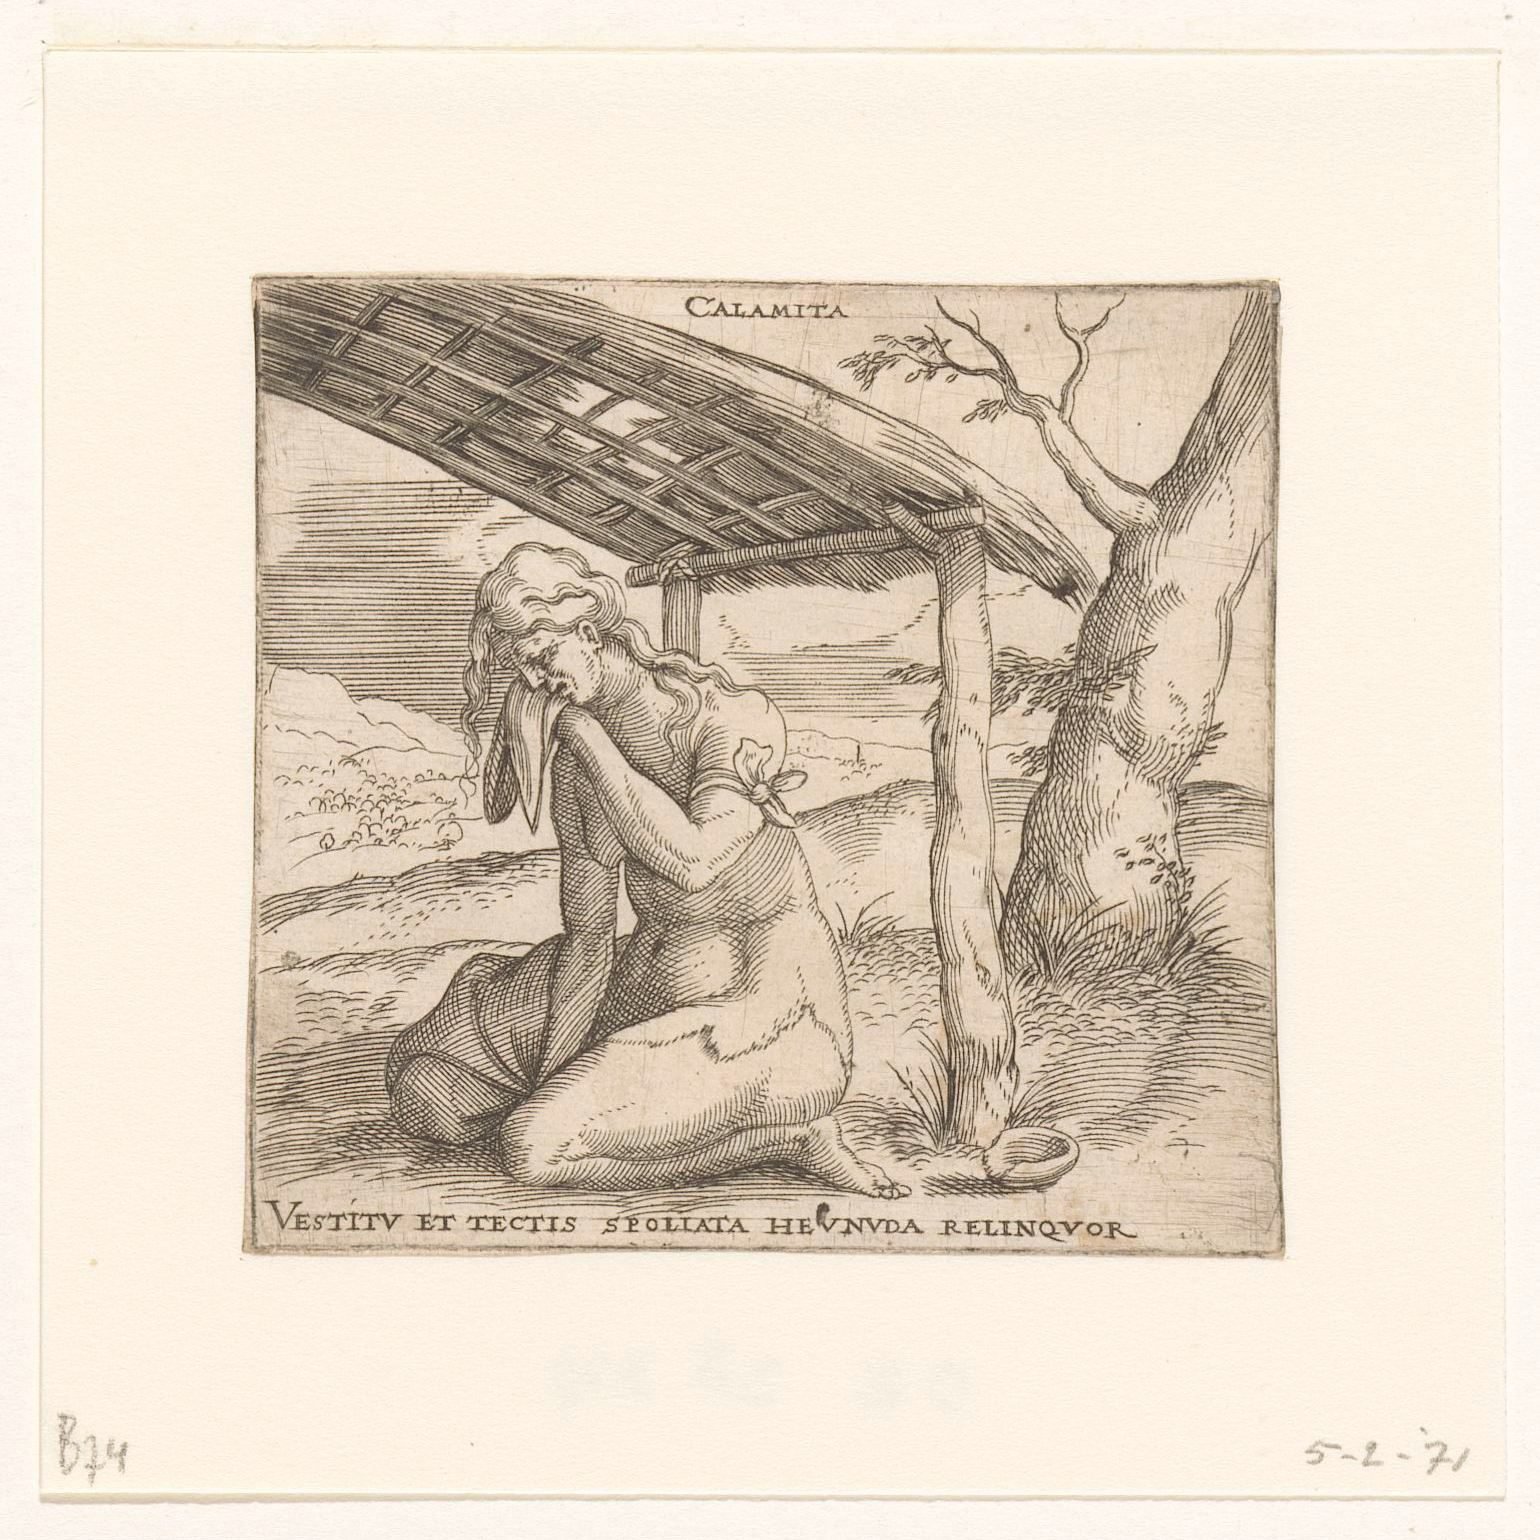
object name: print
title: Onheil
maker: francesco salviati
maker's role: draughtsman, painter, print maker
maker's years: 1510-1563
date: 1533-1567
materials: paper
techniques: engraving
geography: italy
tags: calamity, distress; 'calamità', 'calamità o miseria' (ripa)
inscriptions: collector's mark: Lugt 240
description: Een in vodden geklede vrouw zit geknield en treurend in een landschap onder een afdak. Onderaan een regel Latijnse tekst.